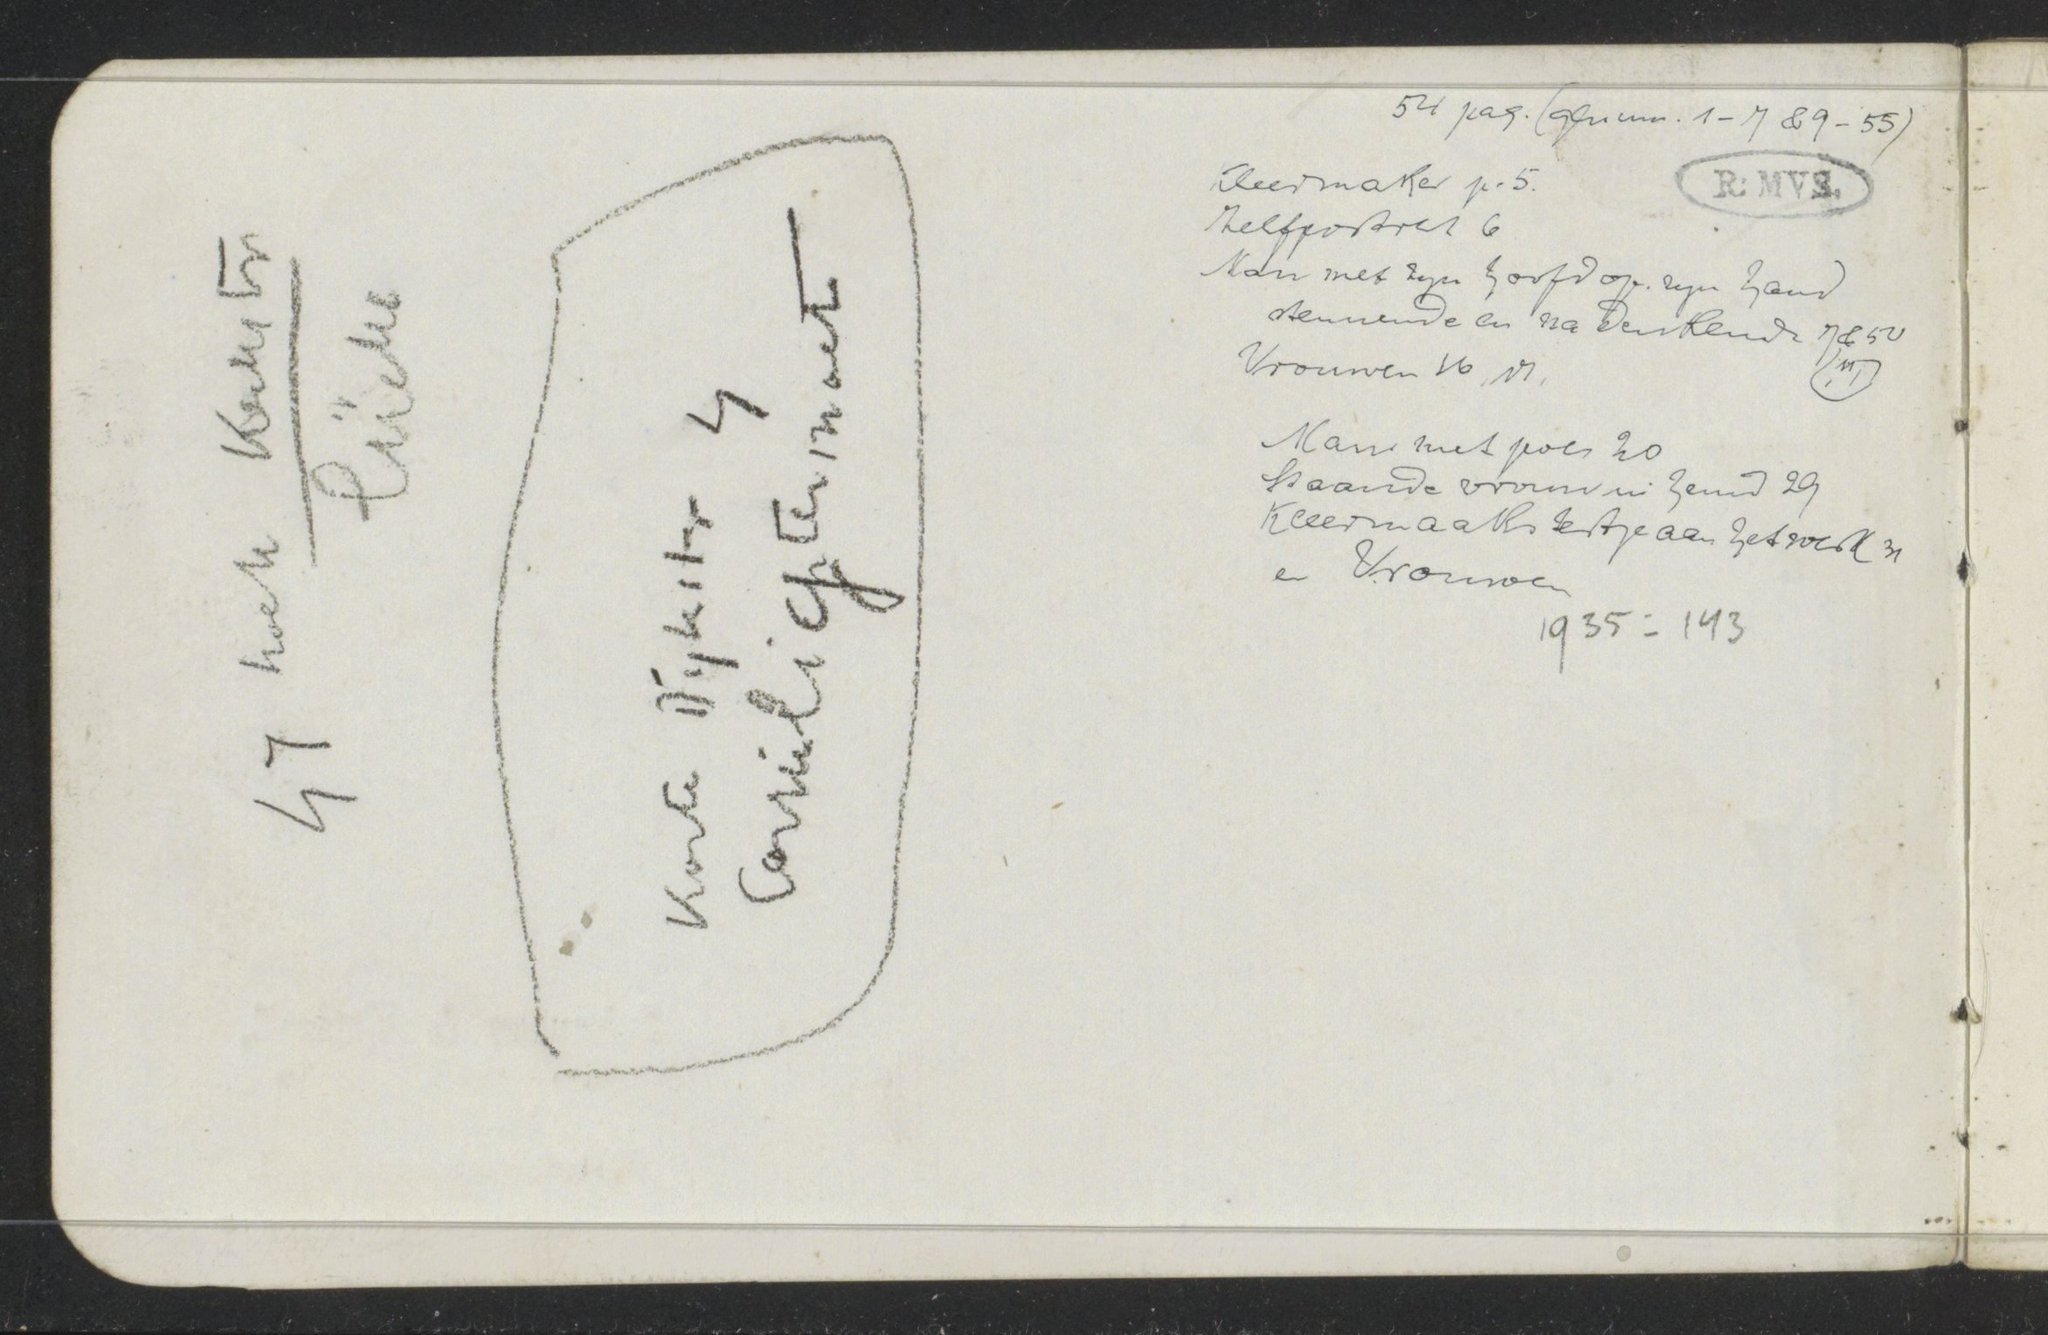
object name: sketchbook leaf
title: Annotaties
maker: isaac israels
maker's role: draughtsman, painter, print maker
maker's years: 1865-1934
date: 1875-1934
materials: chalk, paper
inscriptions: collector's mark: Lugt 2228, annotation: ‘47 hoek Kerkstr / Lücke / Korte Dijkstr 4 / [...]’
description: Schutblad A, voorste schutblad, uit schetsboek LXII met 28 bladen.